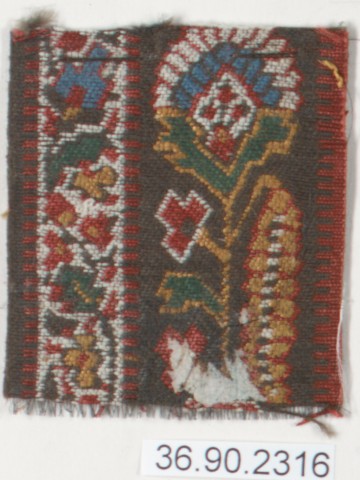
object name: border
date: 1801-1900